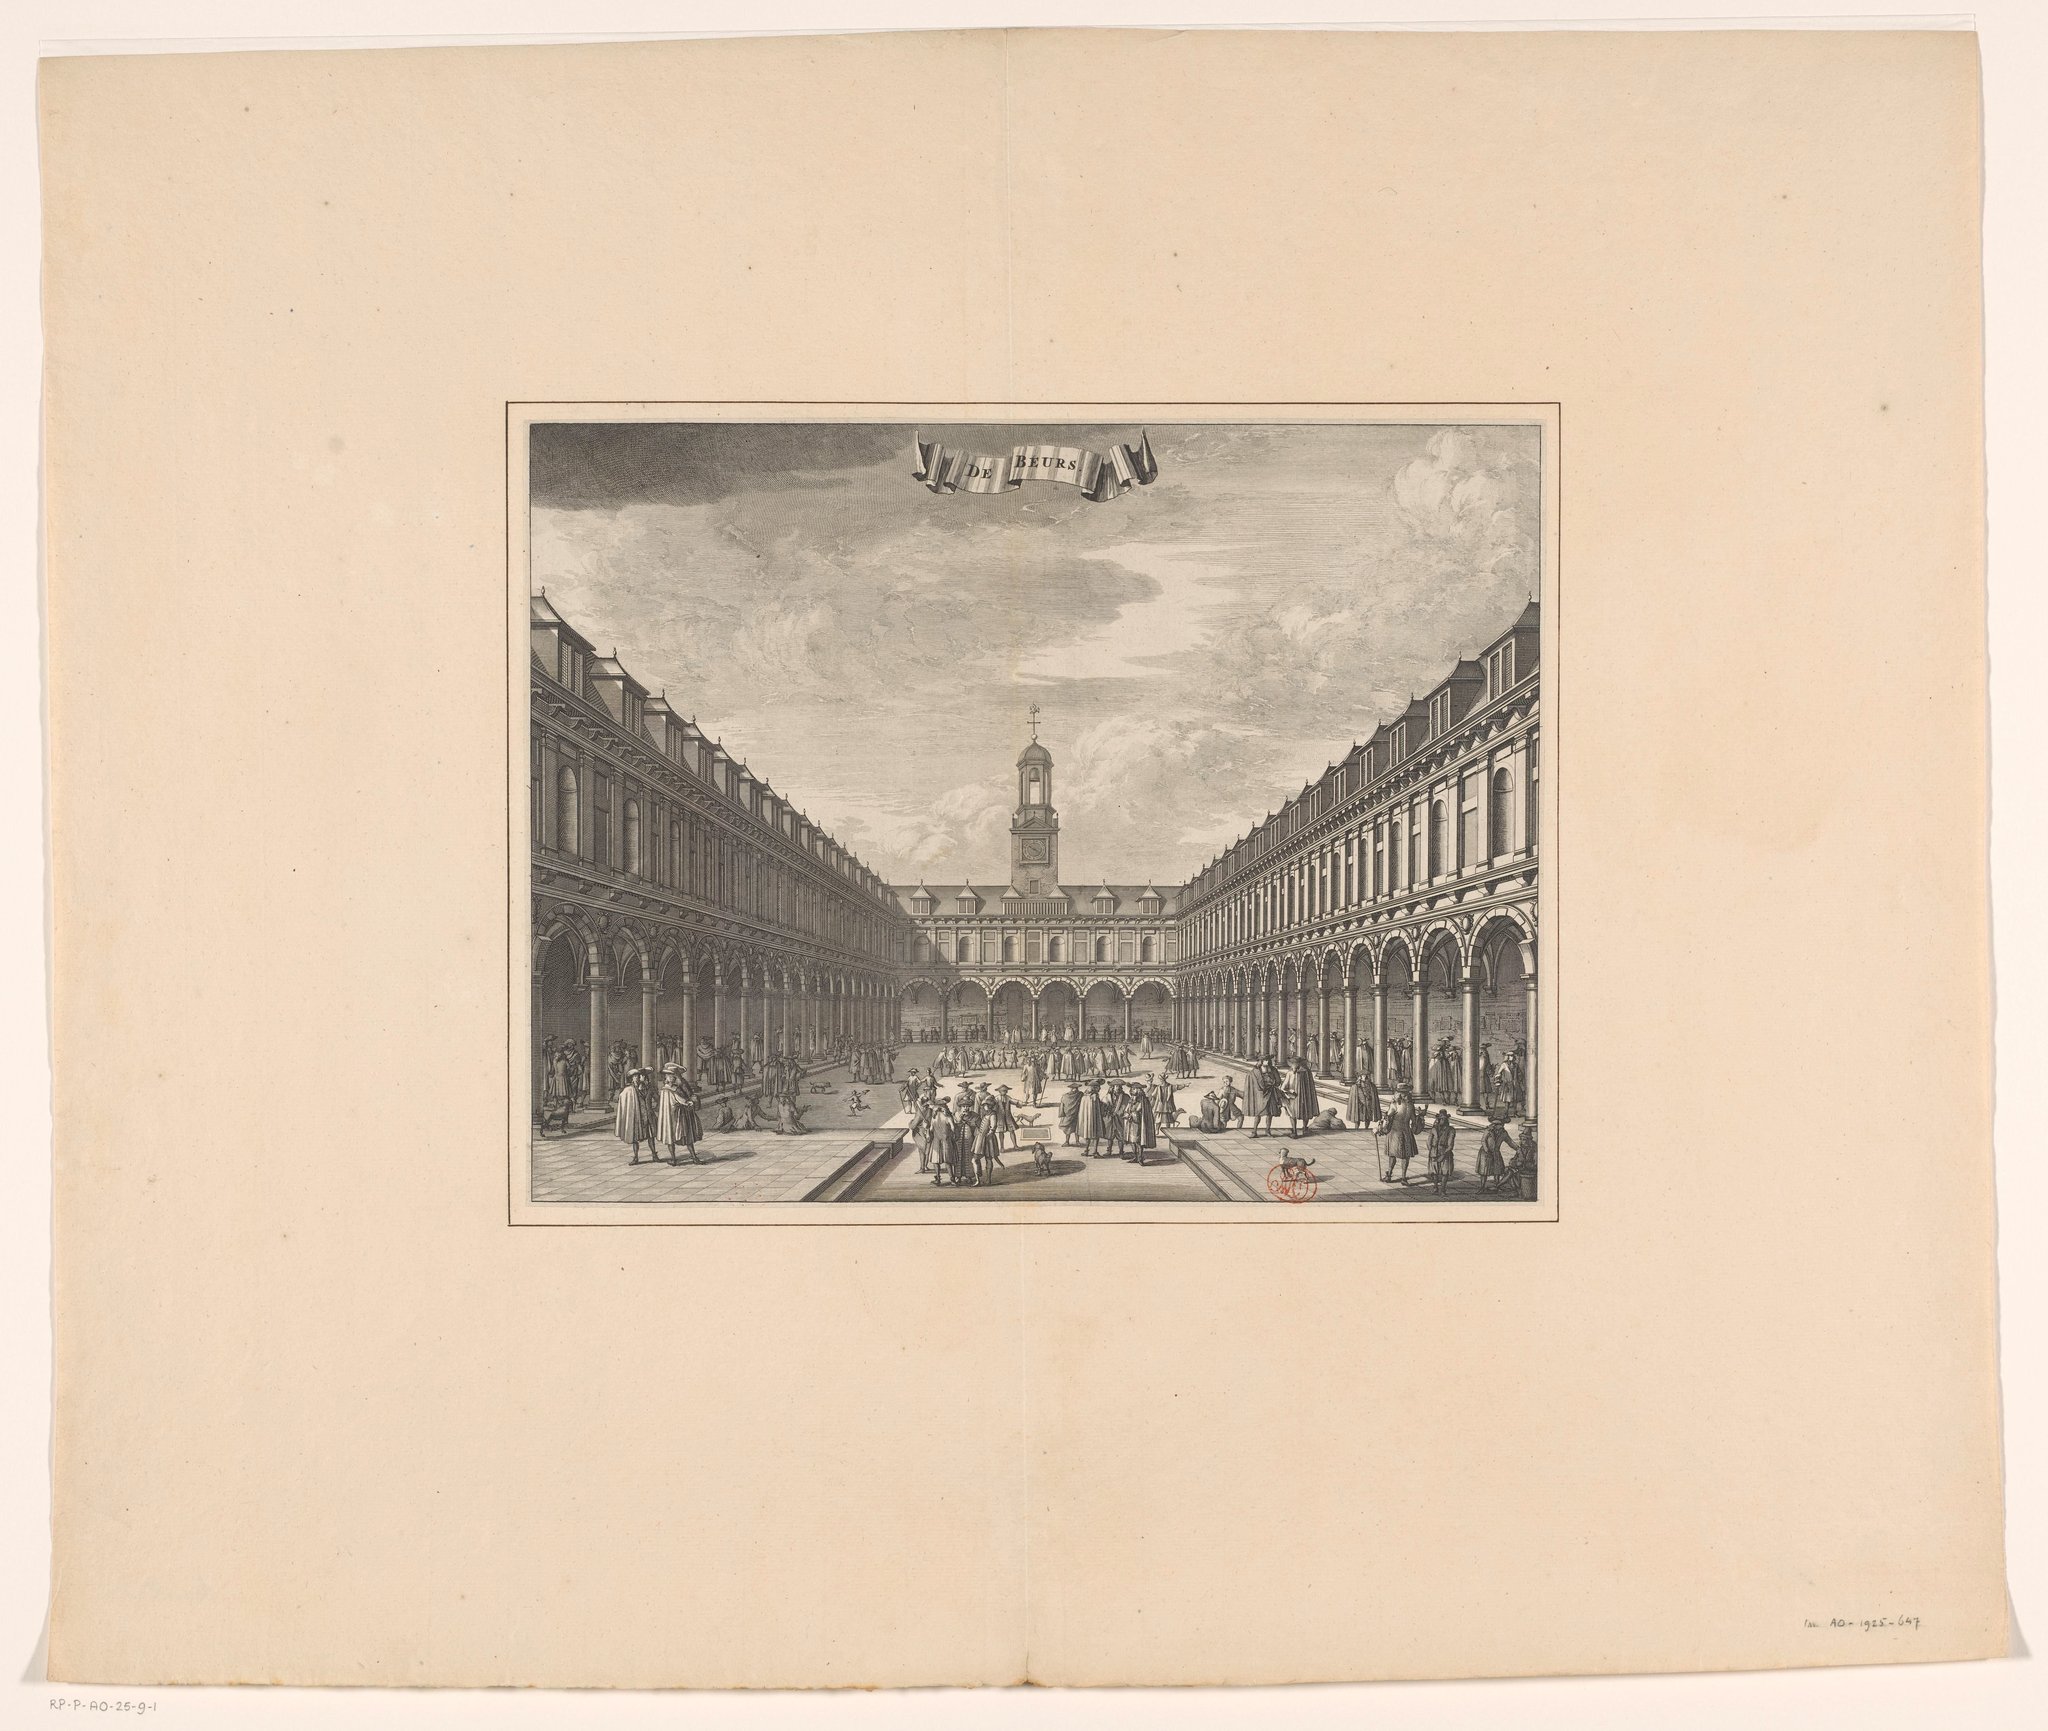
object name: print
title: De Beurs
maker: Anonymous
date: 1693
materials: paper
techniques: engraving, etching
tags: courtyard, exchange, bourse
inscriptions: collector's mark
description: Huidige staat van prent ook gebruikt in: Commelin, Caspar. Beschryvinge van Amsterdam, zynde een naukeurige verhandelinge van desselfs eerste oorspronk uyt (…). 2 delen. 2e druk. Amsterdam: Andries van Damme, Johannes Ratelband, weduwe A. van Aaltwyk en Hermanus Uytwerf, 1726. Eerdere staat van prent ook gebruikt in: Commelin, Caspar. Beschryvinge van Amsterdam, desselfs eerste oorspronk uyt den Huyse (…). 2 delen. Amsterdam: Abraham Wolfgang, Gillis Janssonius van Waesberge, Johannes Janssonius van Waesberge II, weduwe Dirk Boom I, Hendrick Boom en Rembertus Goethals, 1693. En in: Commelin, Caspar. Beschryvinge van Amsterdam, zynde een naukeurige verhandelinge van desselfs eerste oorspronk uyt (…). 2 delen. Amsterdam: weduwe Aart Dircksz Oossaan, 1694.